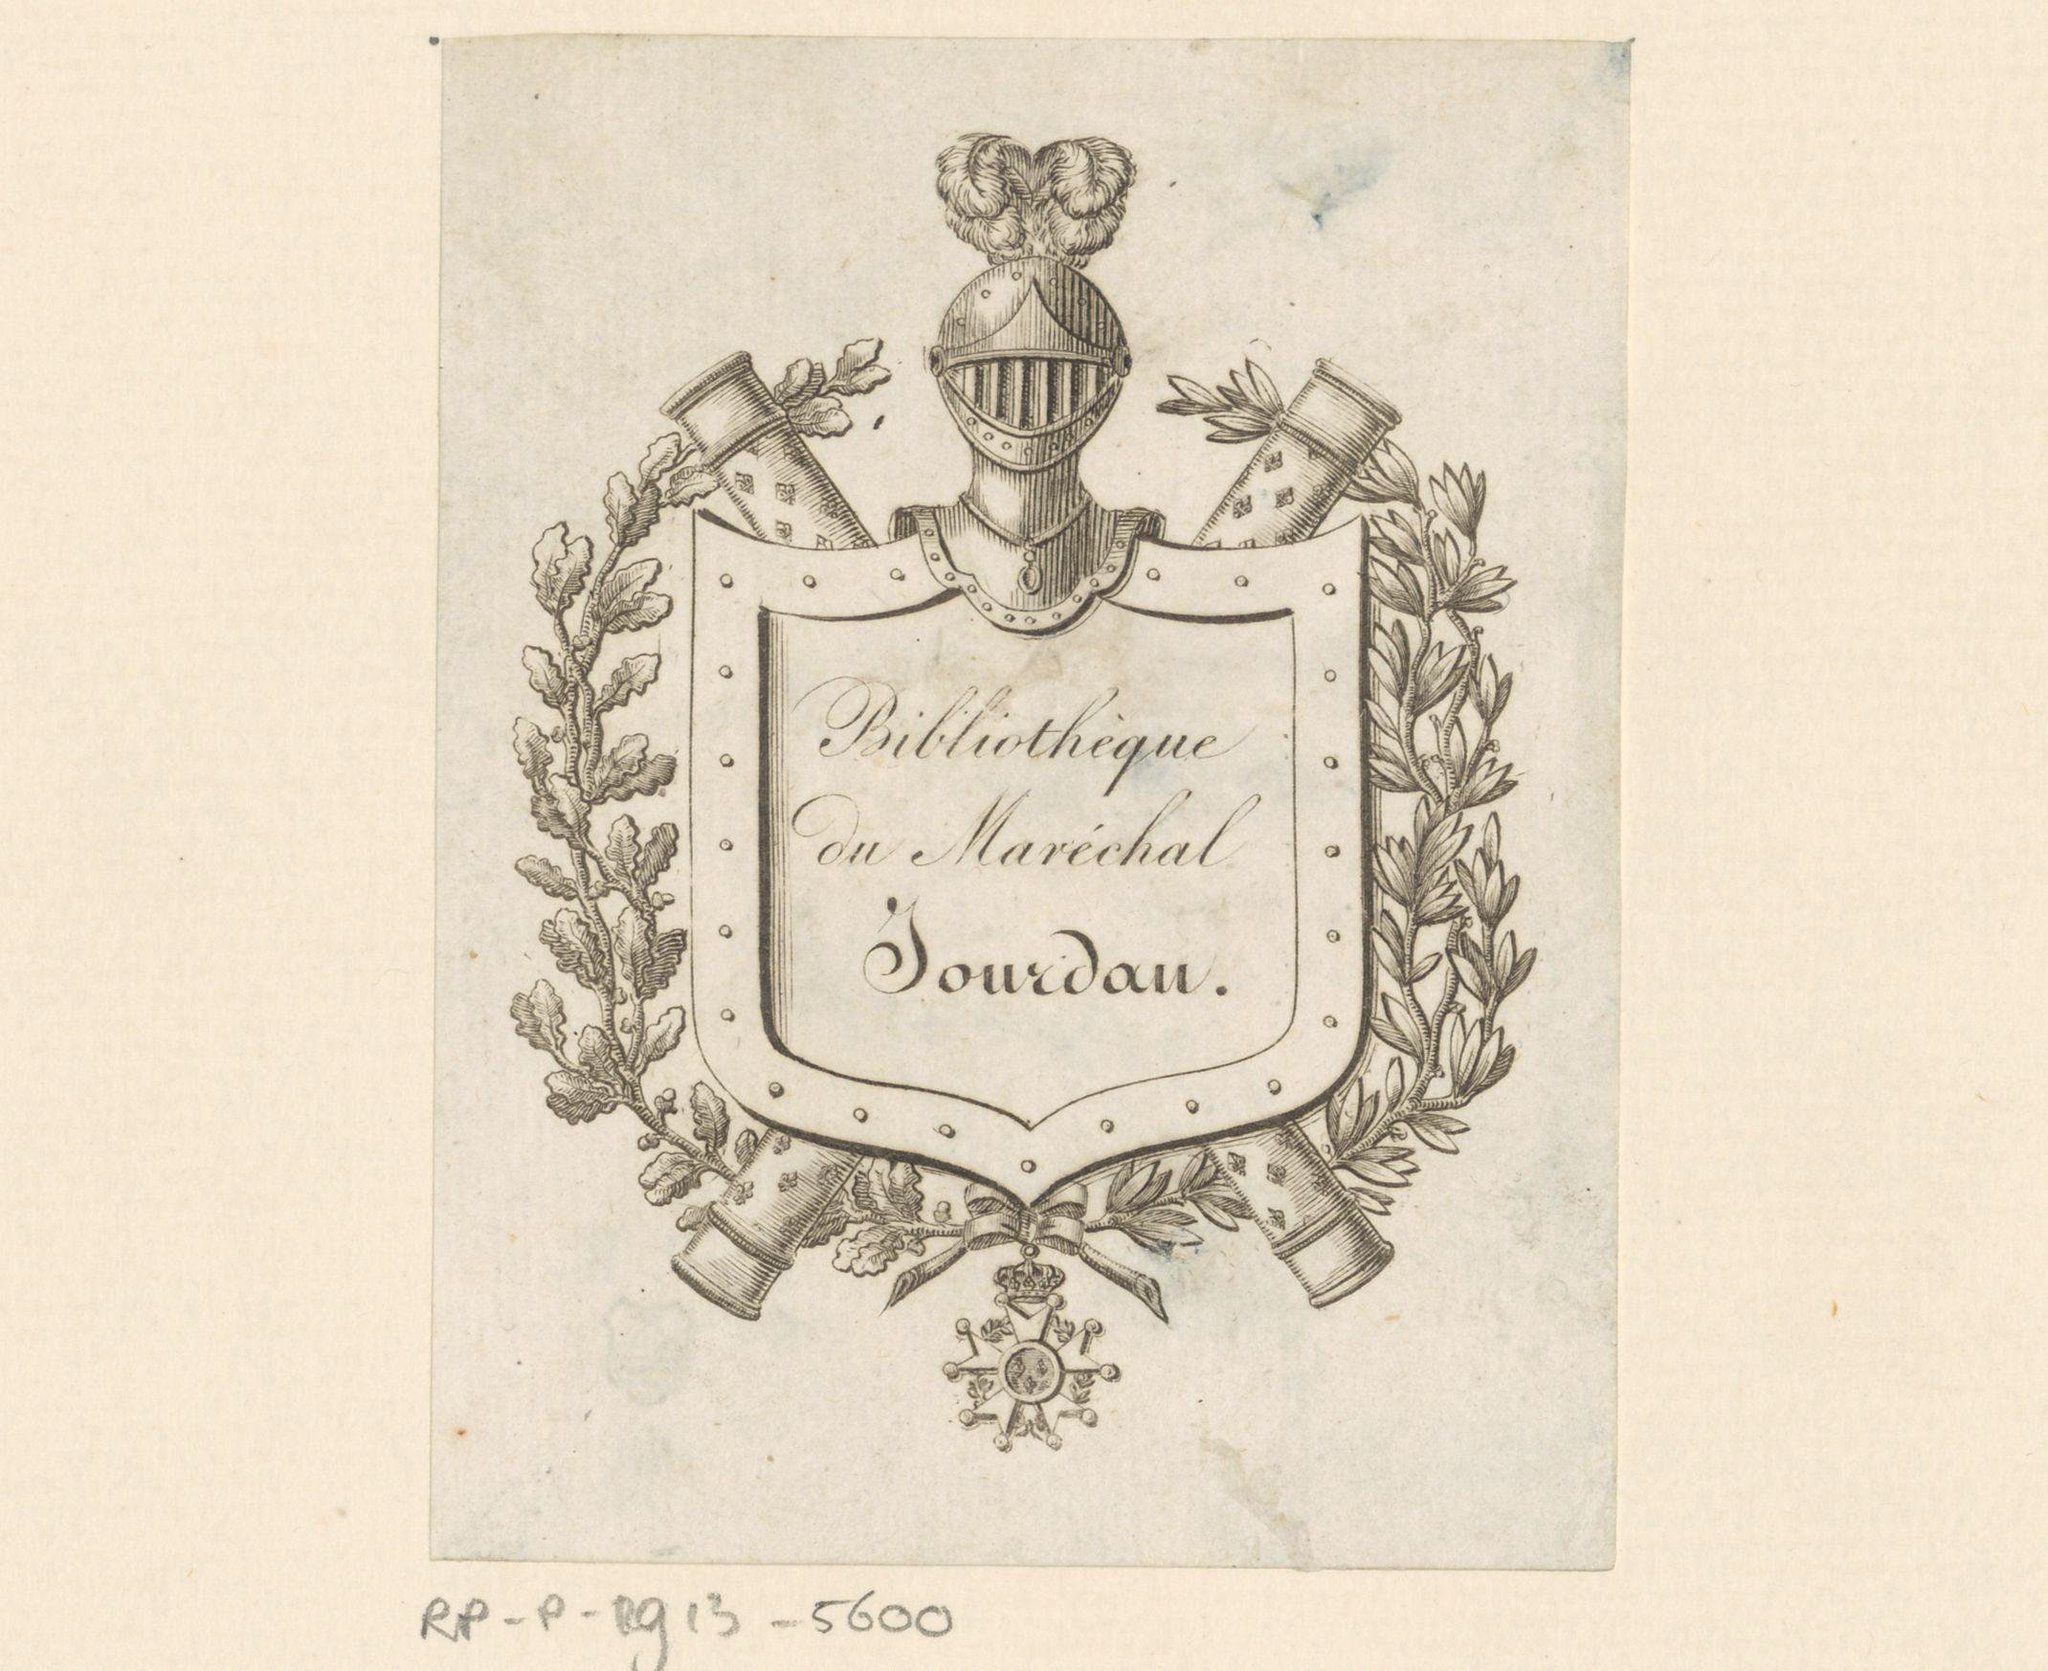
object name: bookplate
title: Bibliothèque du Maréchal Jourdan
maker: Anonymous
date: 1773-1833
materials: paper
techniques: engraving, etching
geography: france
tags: politician, armour, trees: oak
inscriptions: collector's mark: Lugt 2233, collector's mark: Lugt 2760